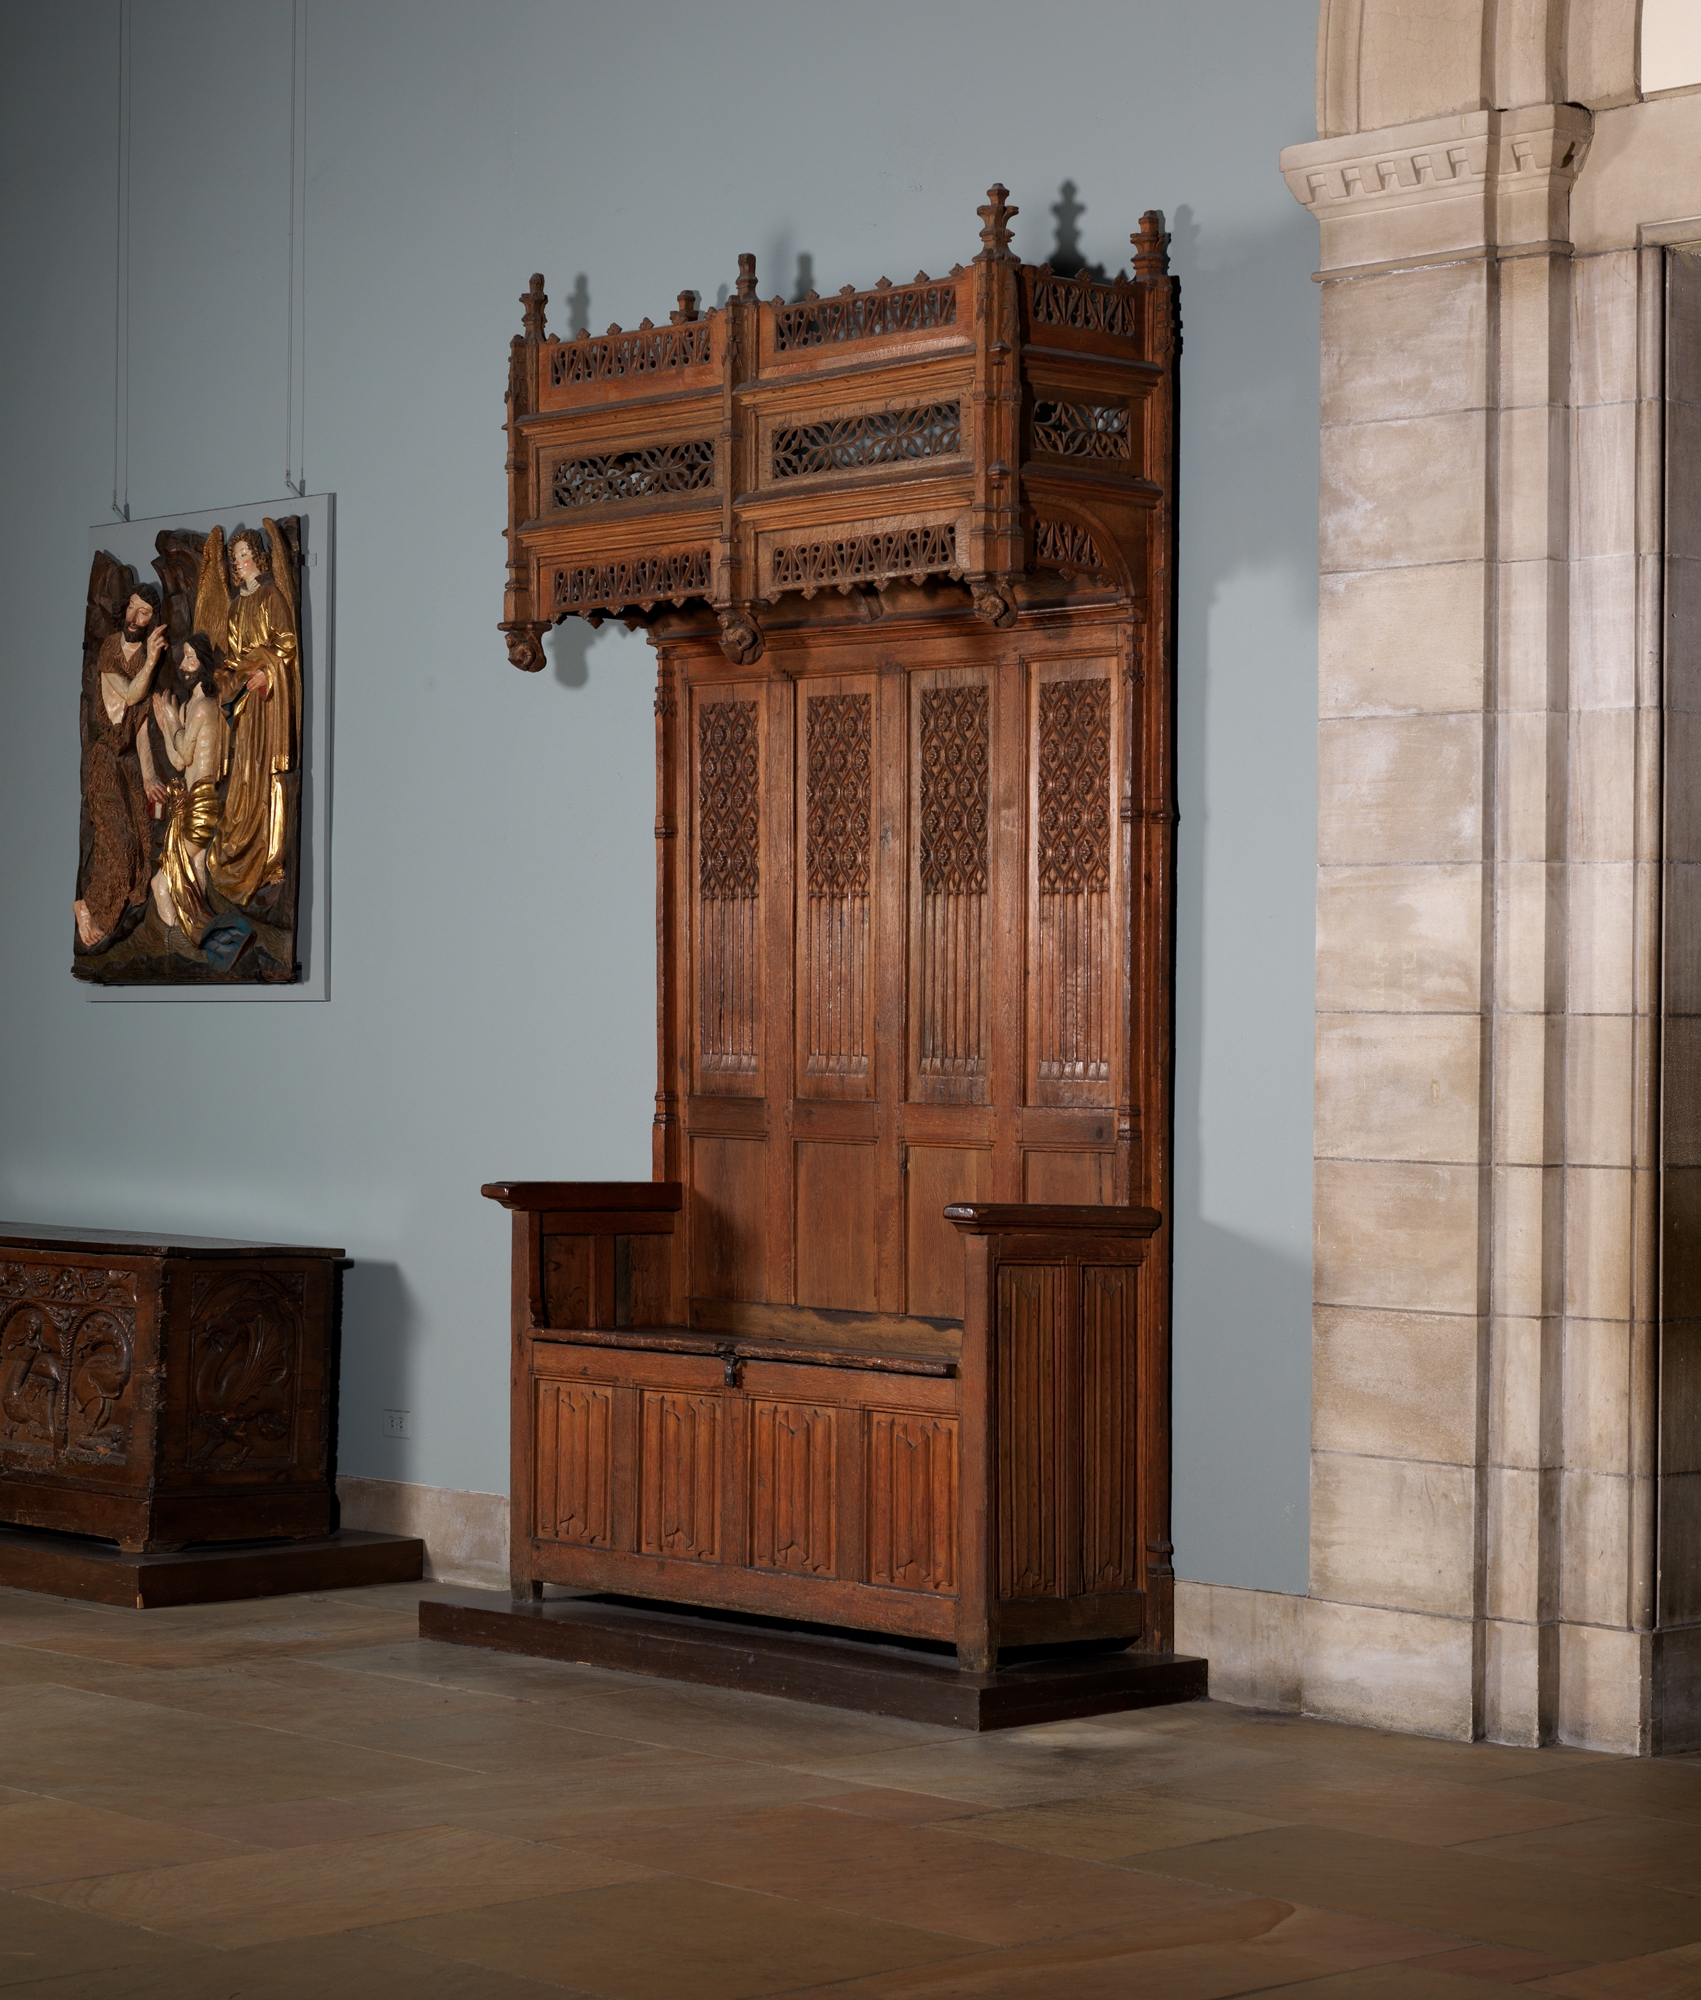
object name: seat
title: Canopied Seat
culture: french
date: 1500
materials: wood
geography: france